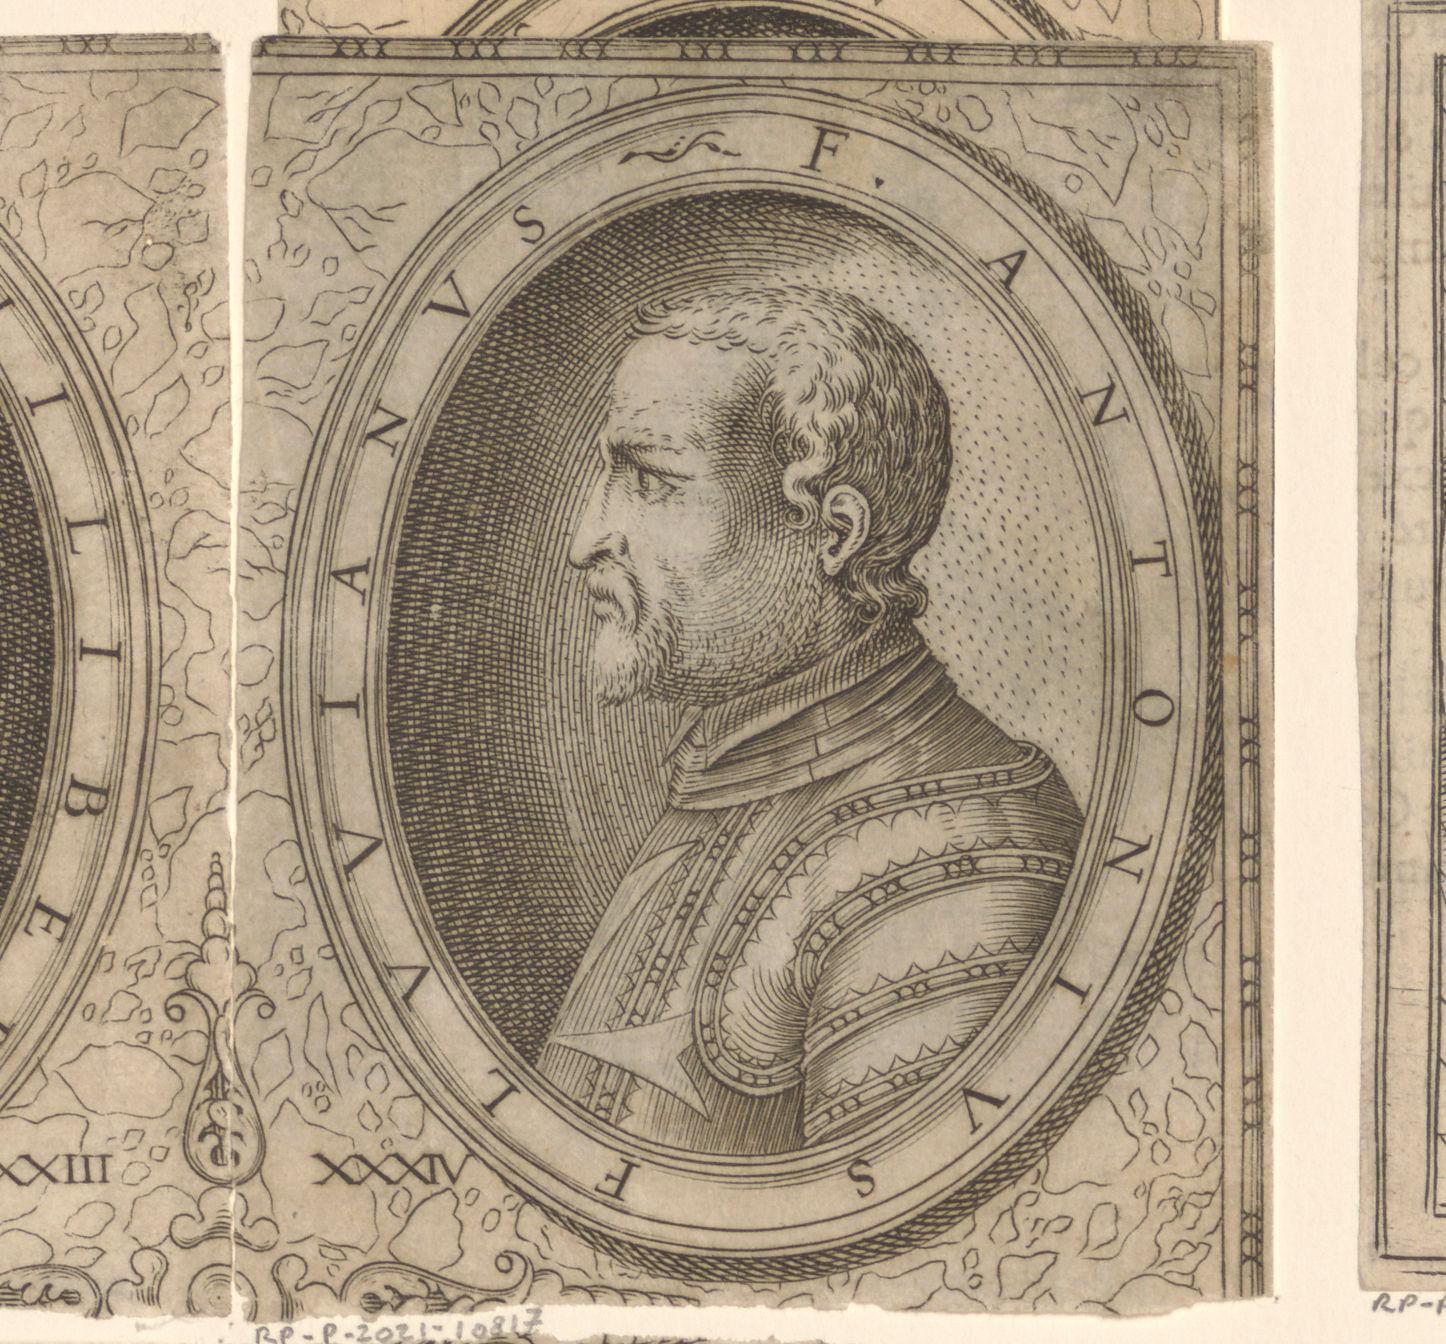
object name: print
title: Portret van Antonio de Fluvià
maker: philippe thomassin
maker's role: print maker, publisher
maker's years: 1562-1622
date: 1588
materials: paper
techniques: engraving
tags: historical persons, military orders, e.g.: knights templars, knights of malta, teutonic knights ~ roman catholic church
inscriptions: collector's mark: Lugt 2228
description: Deze prent maakt deel uit van een grotere prent met vier portretten die later is verknipt. Prent waarschijnlijk uit: Veltroni, Tolomeo. Statuta hospitalis Hierusalem. [Rome: s.n., 1588].